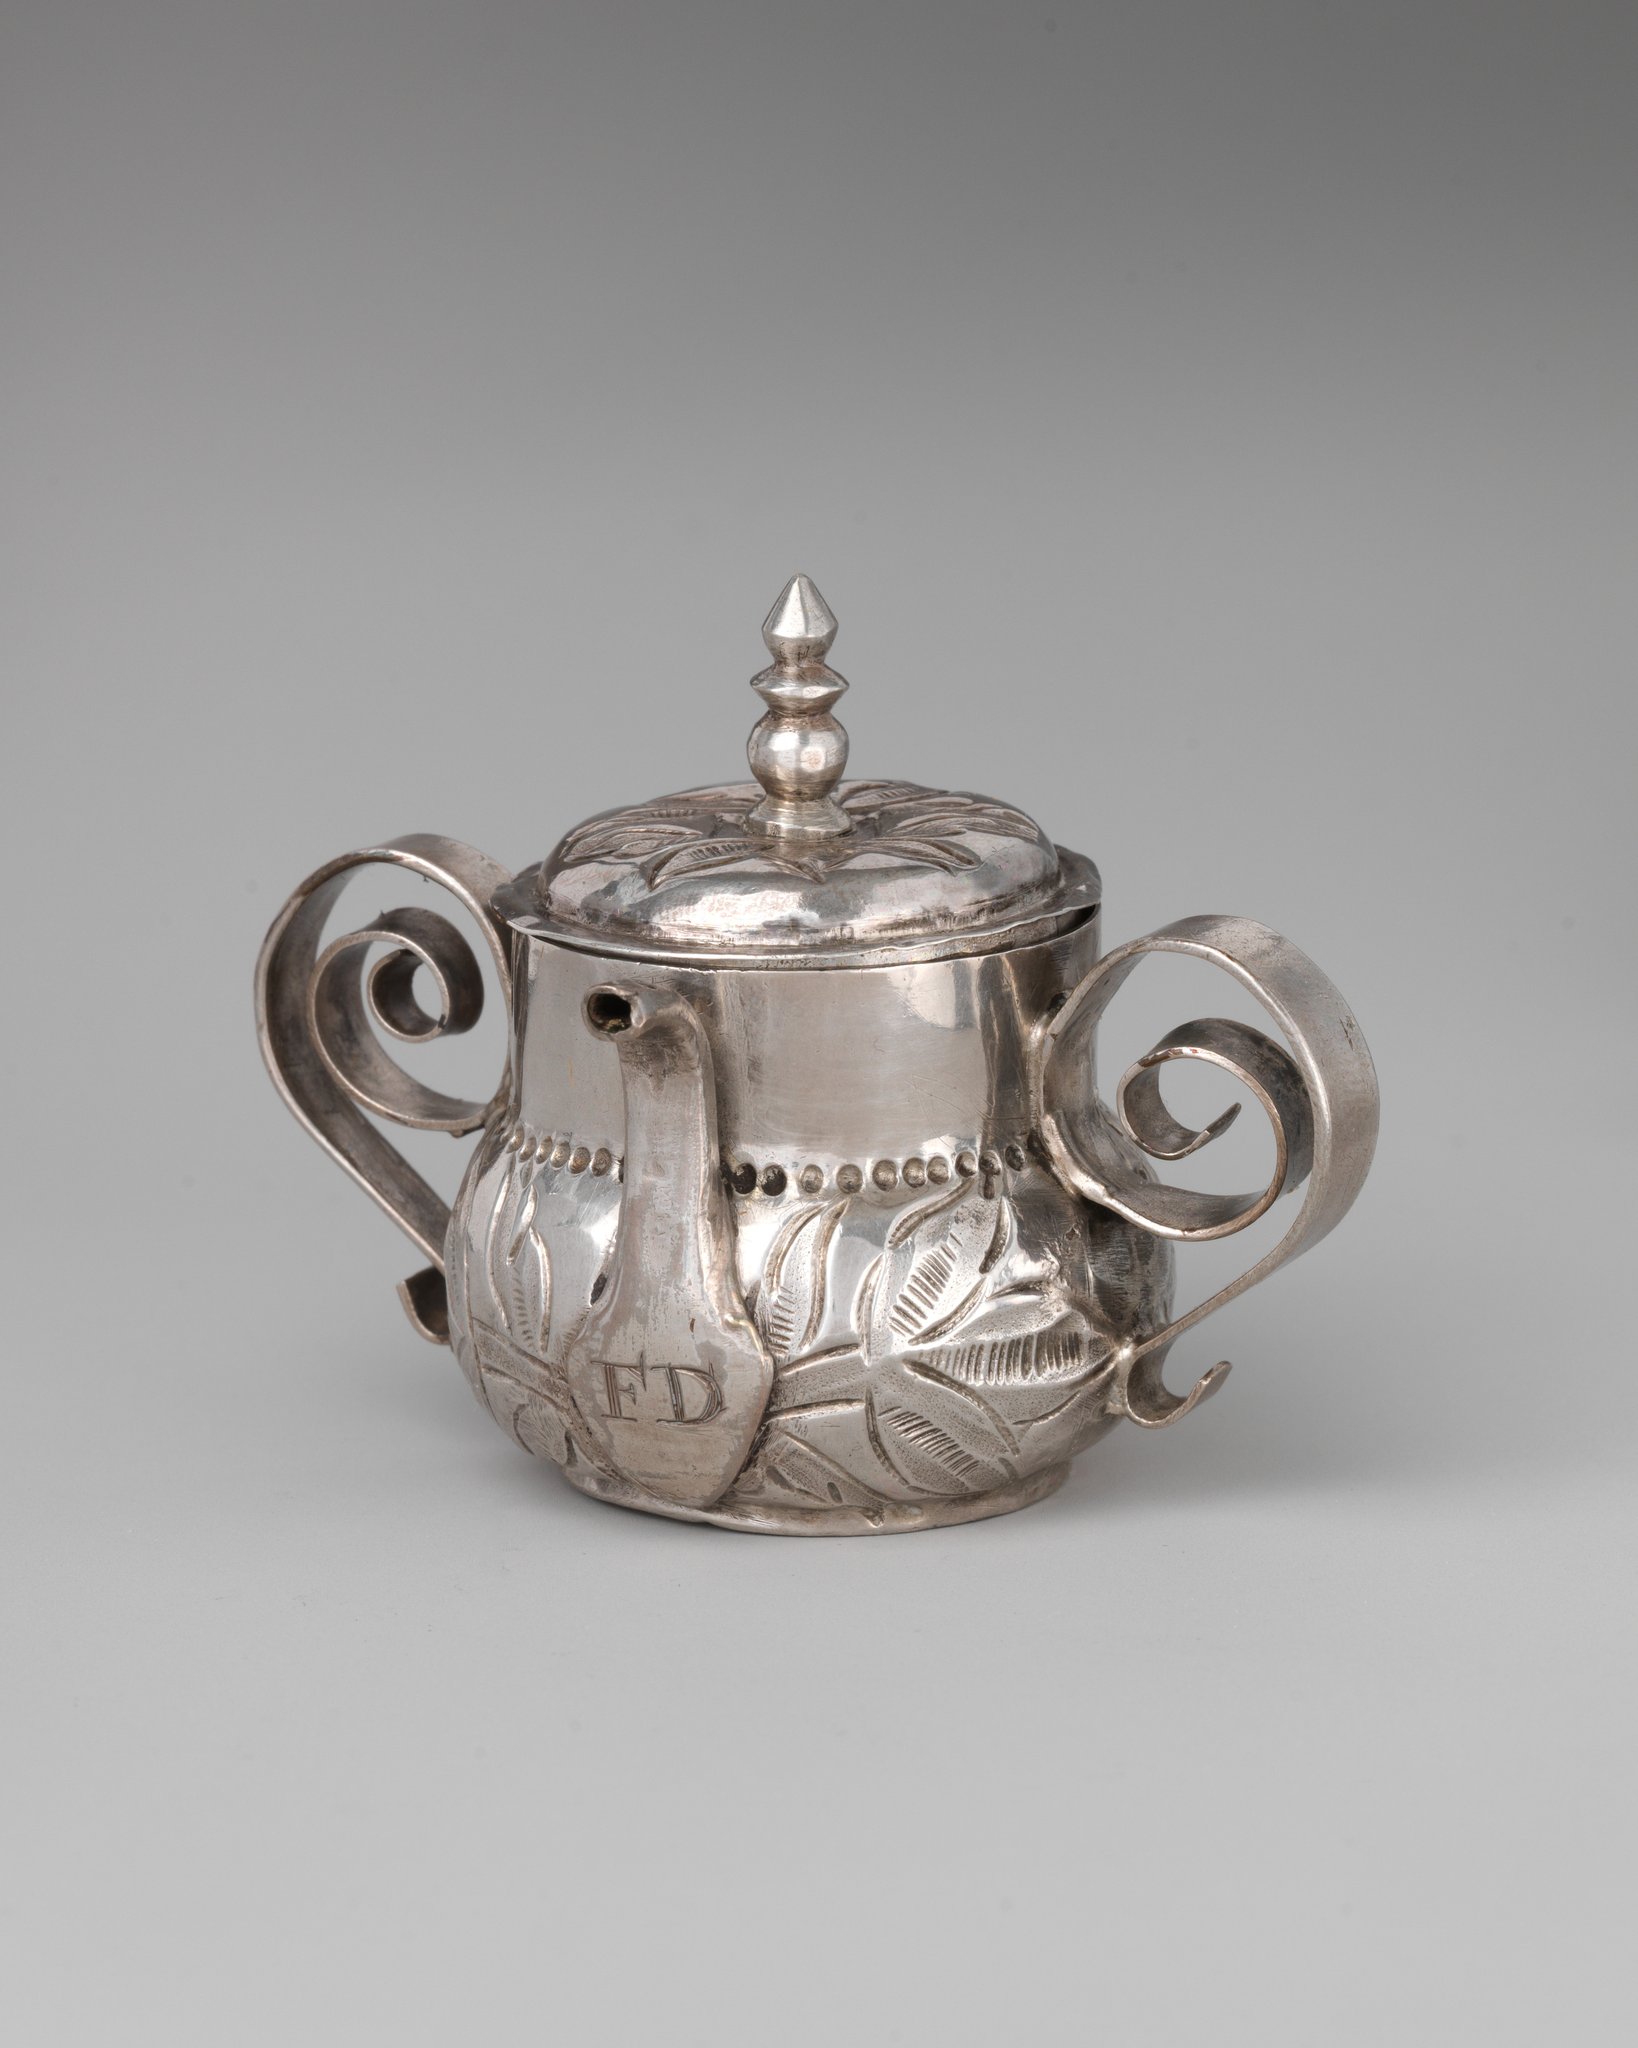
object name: posset cup with cover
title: Miniature posset cup with cover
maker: george manjoy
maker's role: maker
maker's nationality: british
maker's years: 1685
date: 1691-1692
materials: silver